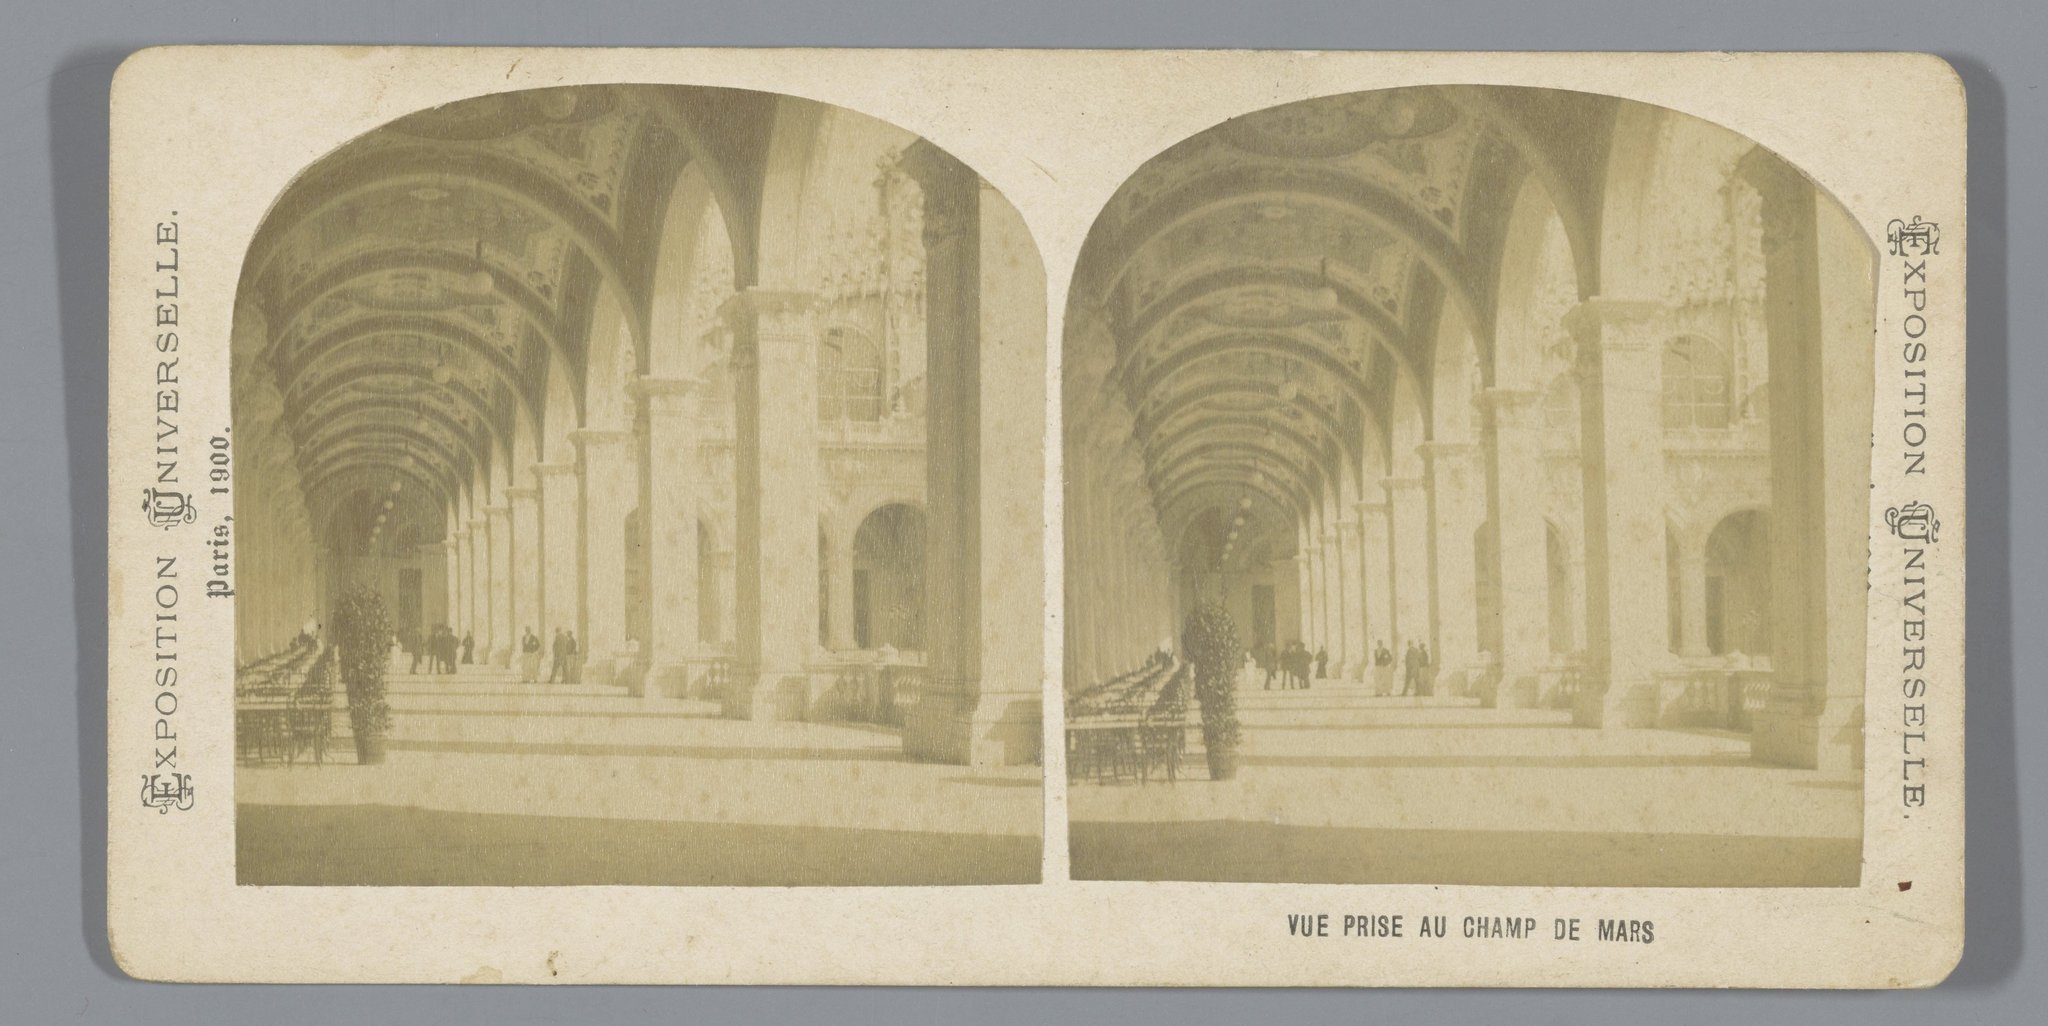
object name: stereograph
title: Exposition Universelle Paris, 1900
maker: Anonymous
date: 1900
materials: cardboard, paper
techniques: albumen print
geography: paris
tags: world fair, world exhibition, gallery (spacious corridor), paris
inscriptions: number: ‘98’